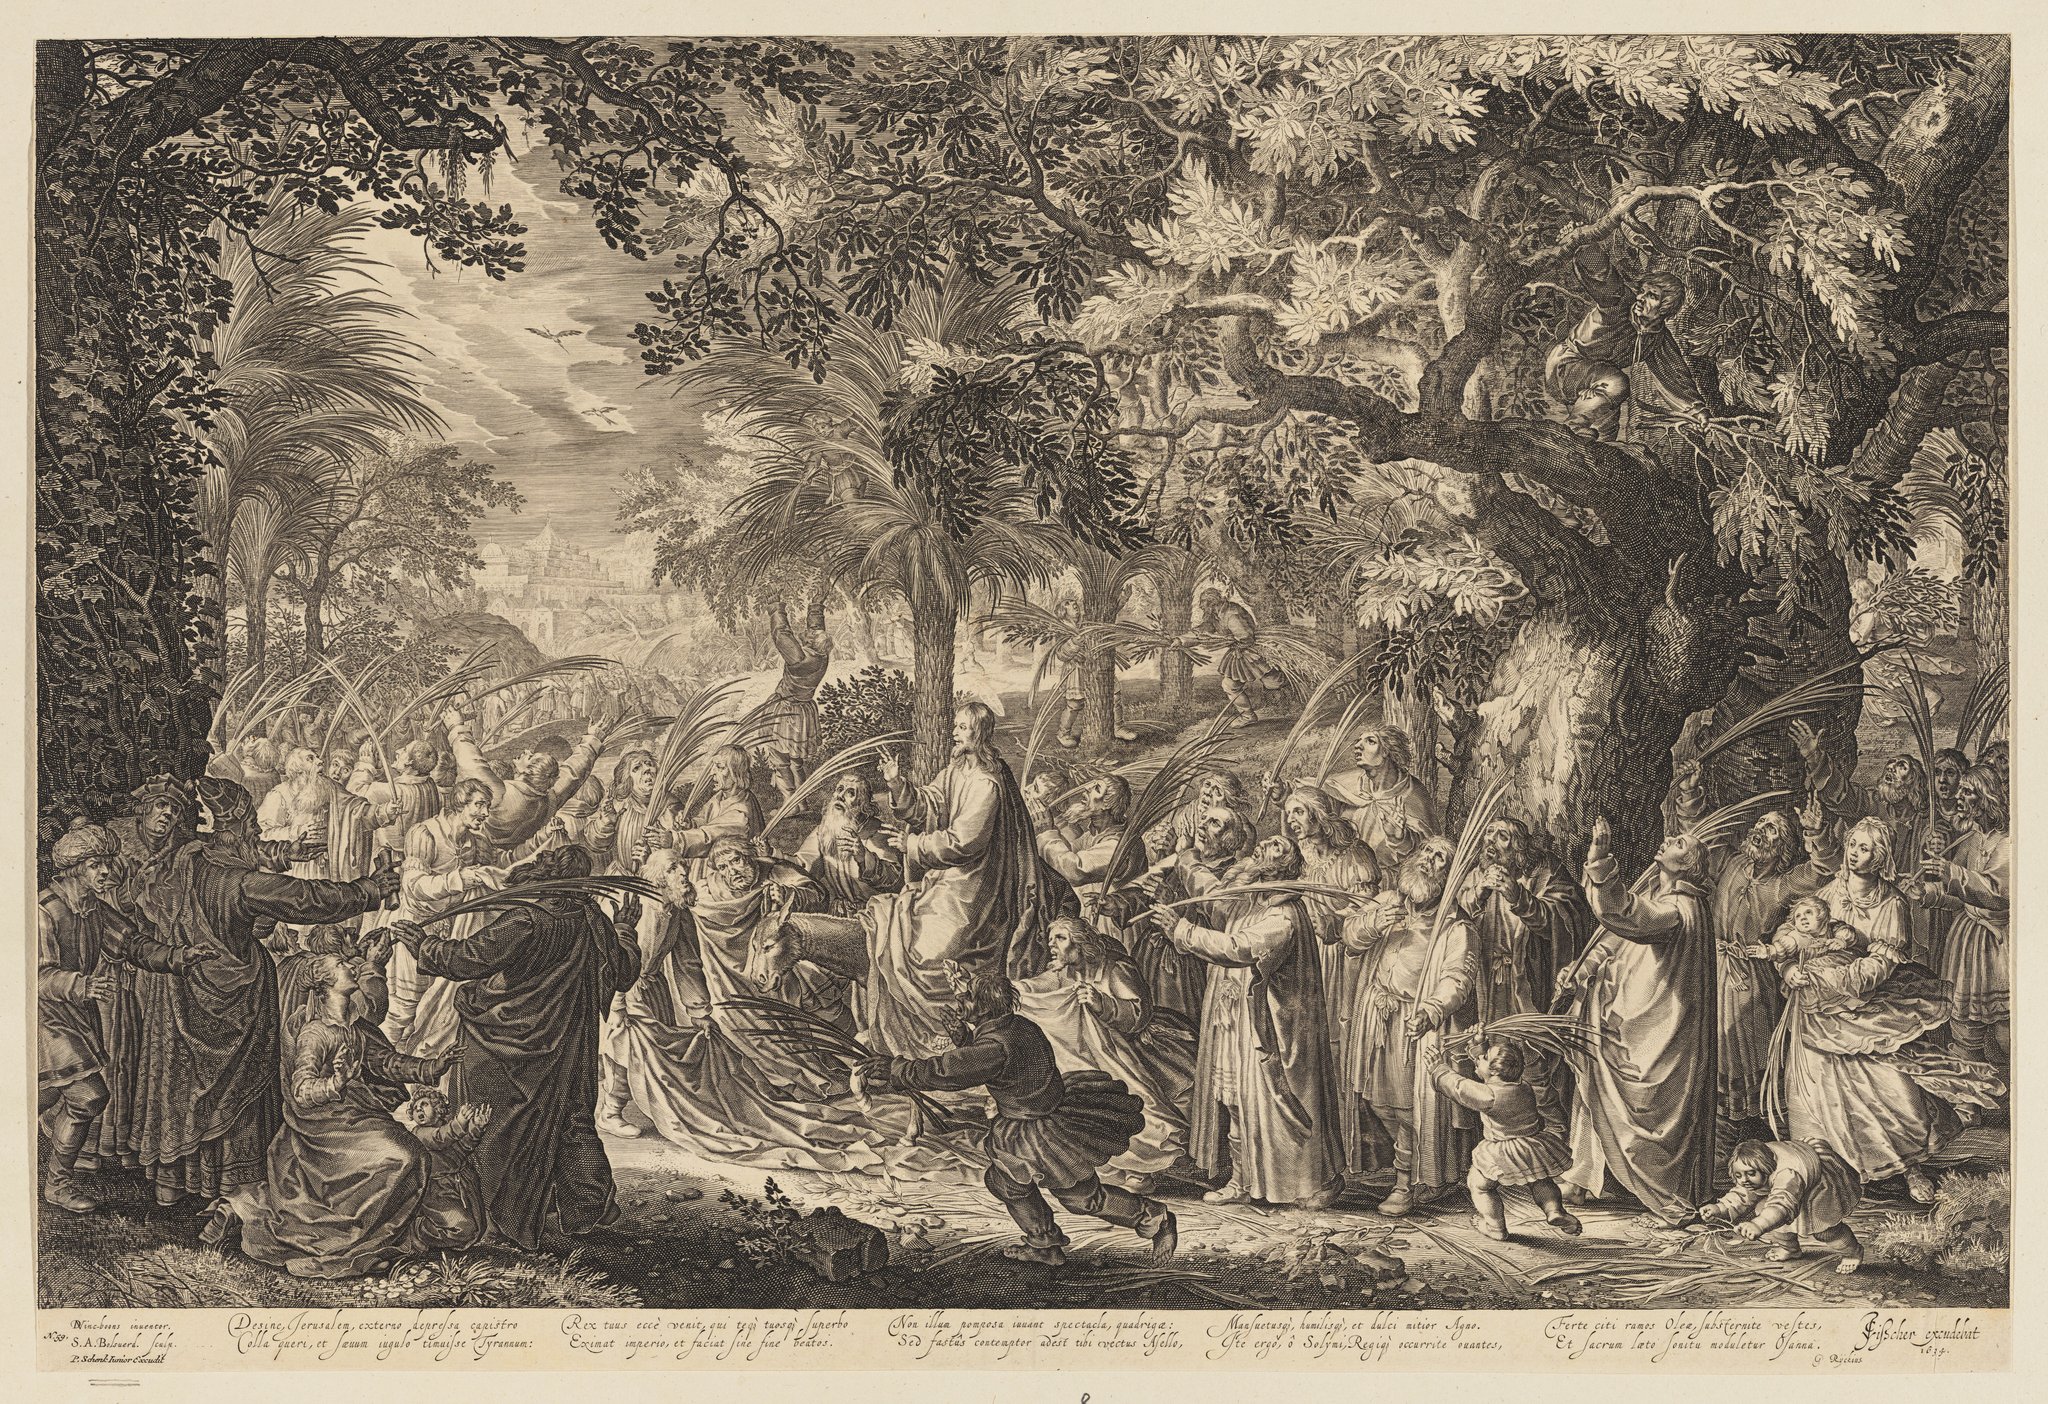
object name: print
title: Christ Entering Jerusalem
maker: david vinckboons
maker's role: artist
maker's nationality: netherlandish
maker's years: 1576-1629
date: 1634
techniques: engraving